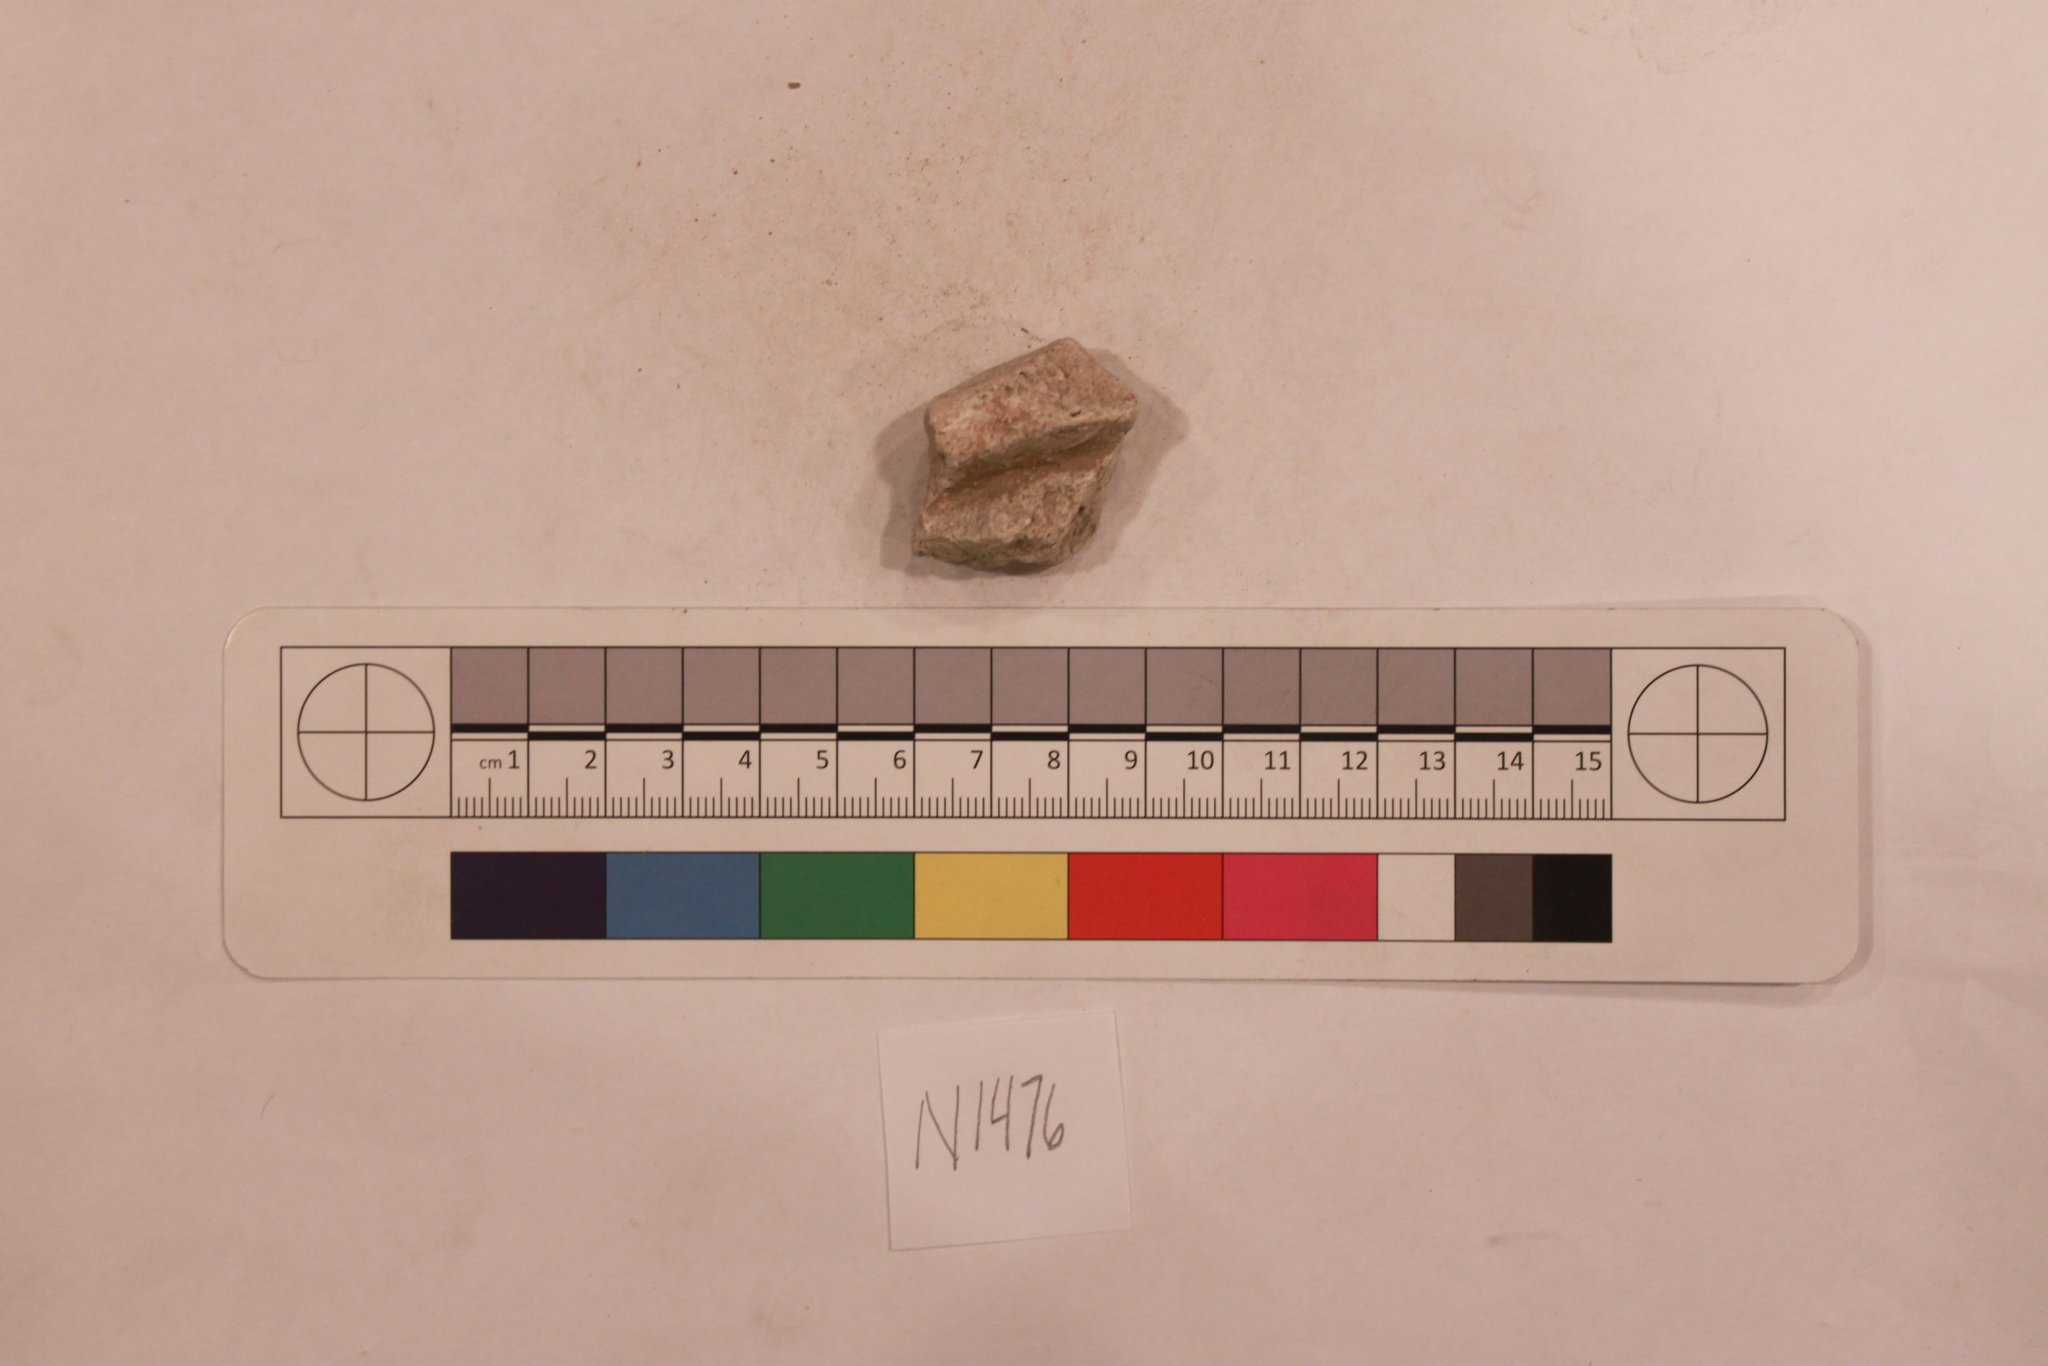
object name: fragment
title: Stucco Fragment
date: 701-1200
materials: plaster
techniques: carving, painting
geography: iran